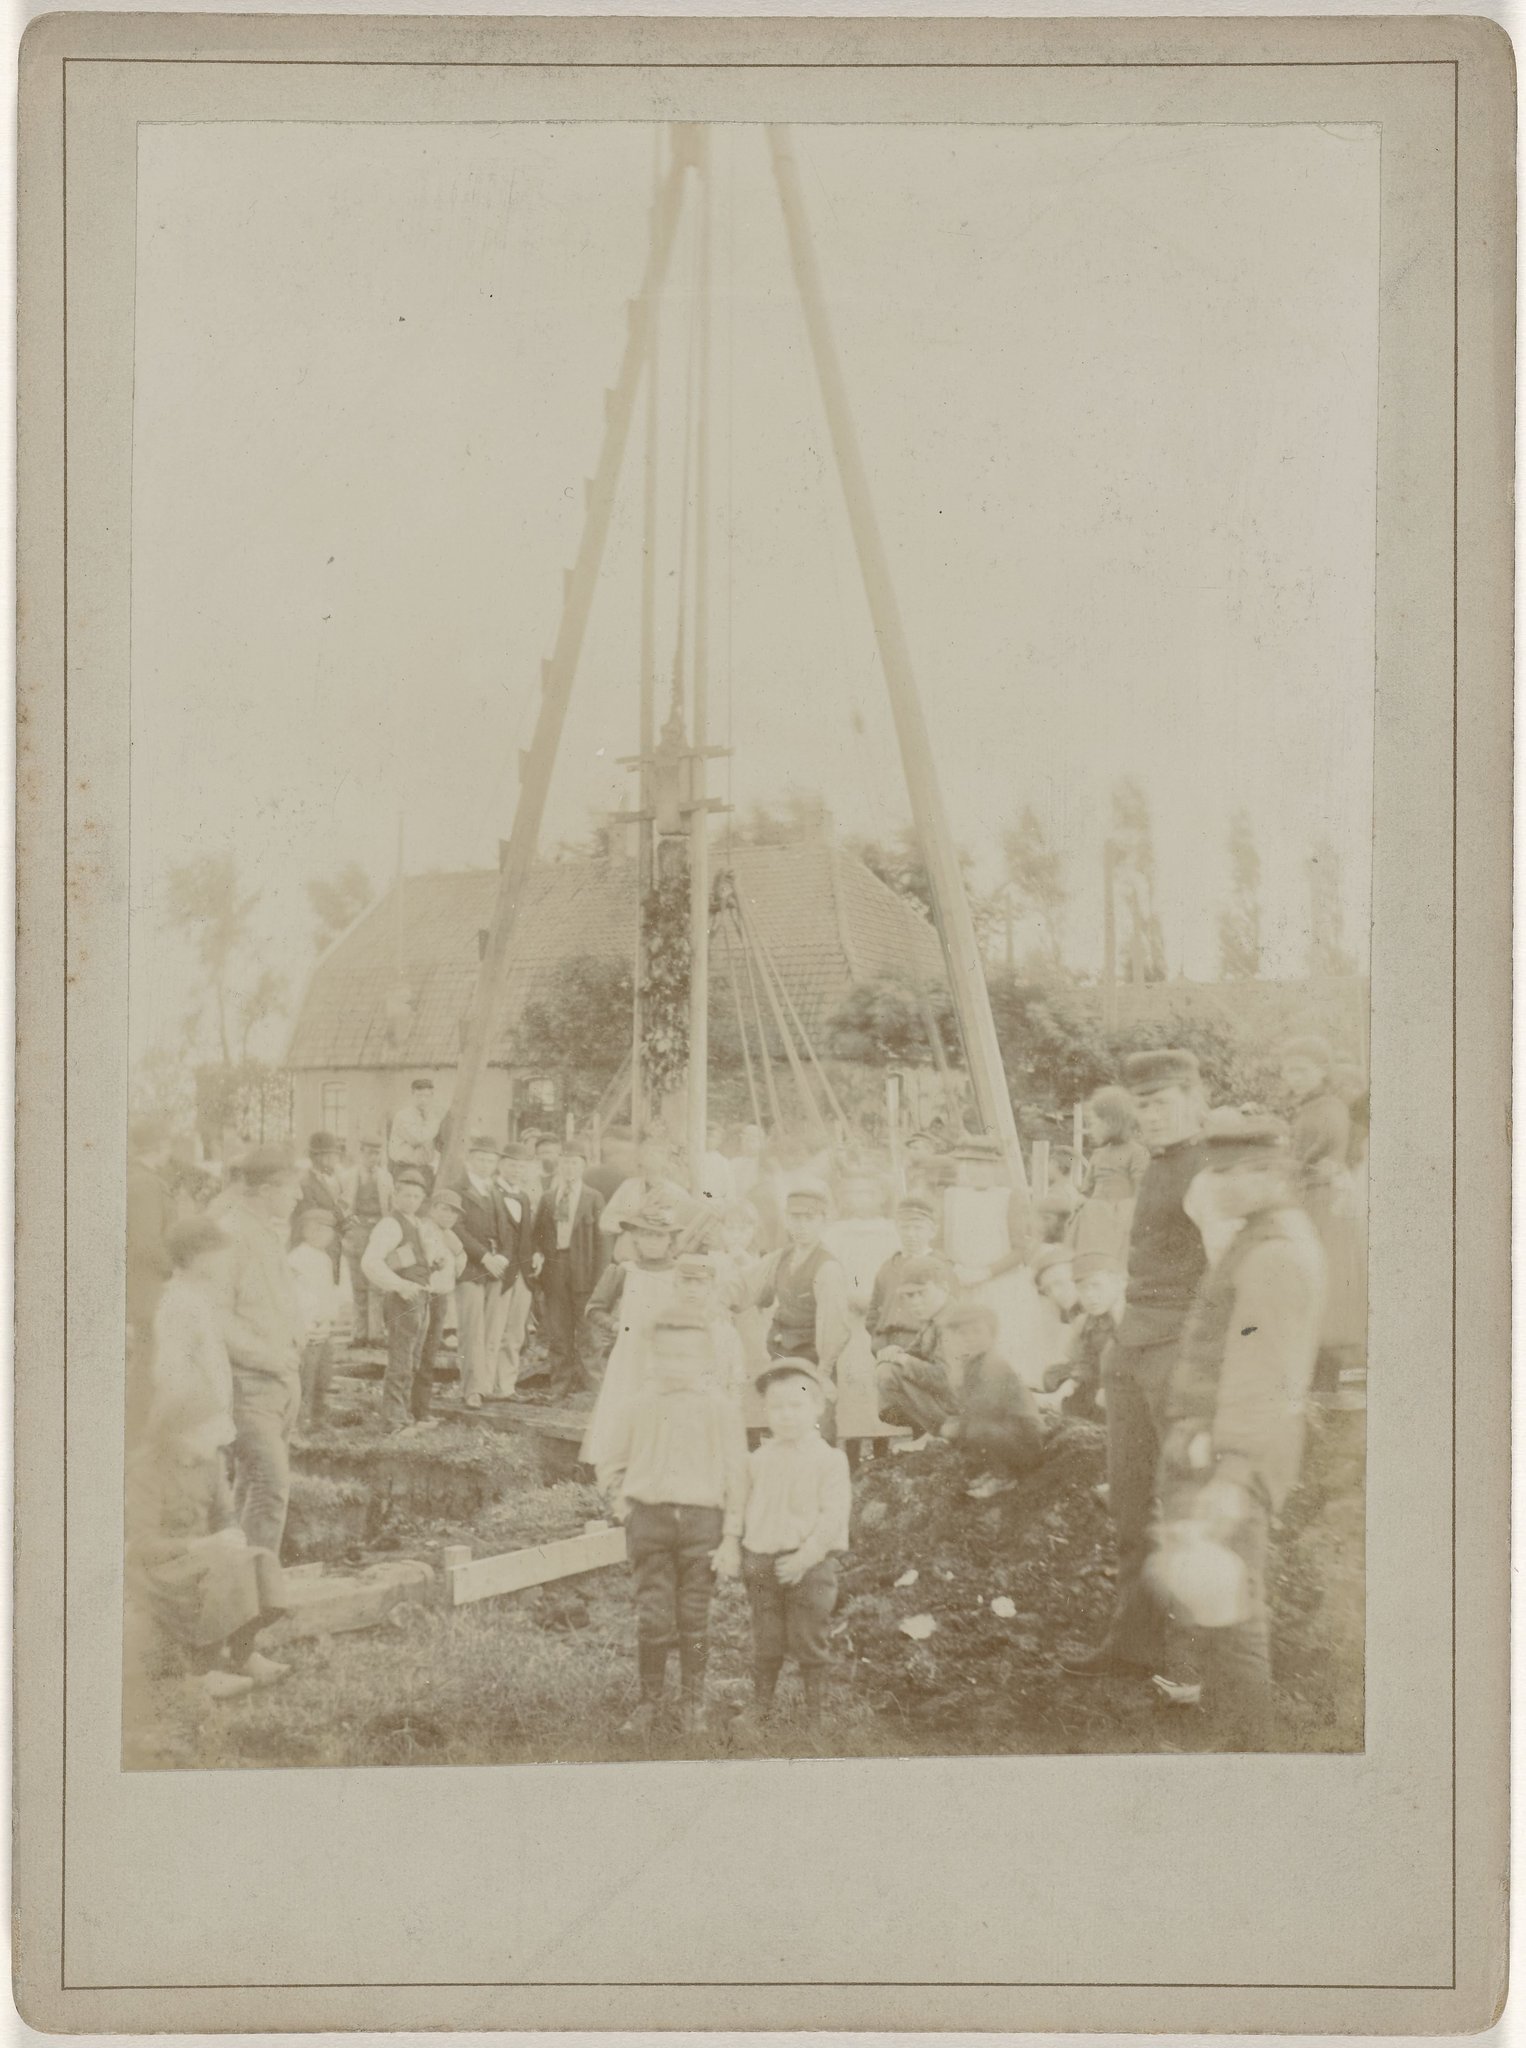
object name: cabinet photograph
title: Menigte bij het slaan van de eerste paal voor een gebouw in Amsterdam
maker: Anonymous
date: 1880-1910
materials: paper, cardboard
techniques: collodion silver print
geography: amsterdam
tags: public festivities, building-site, amsterdam